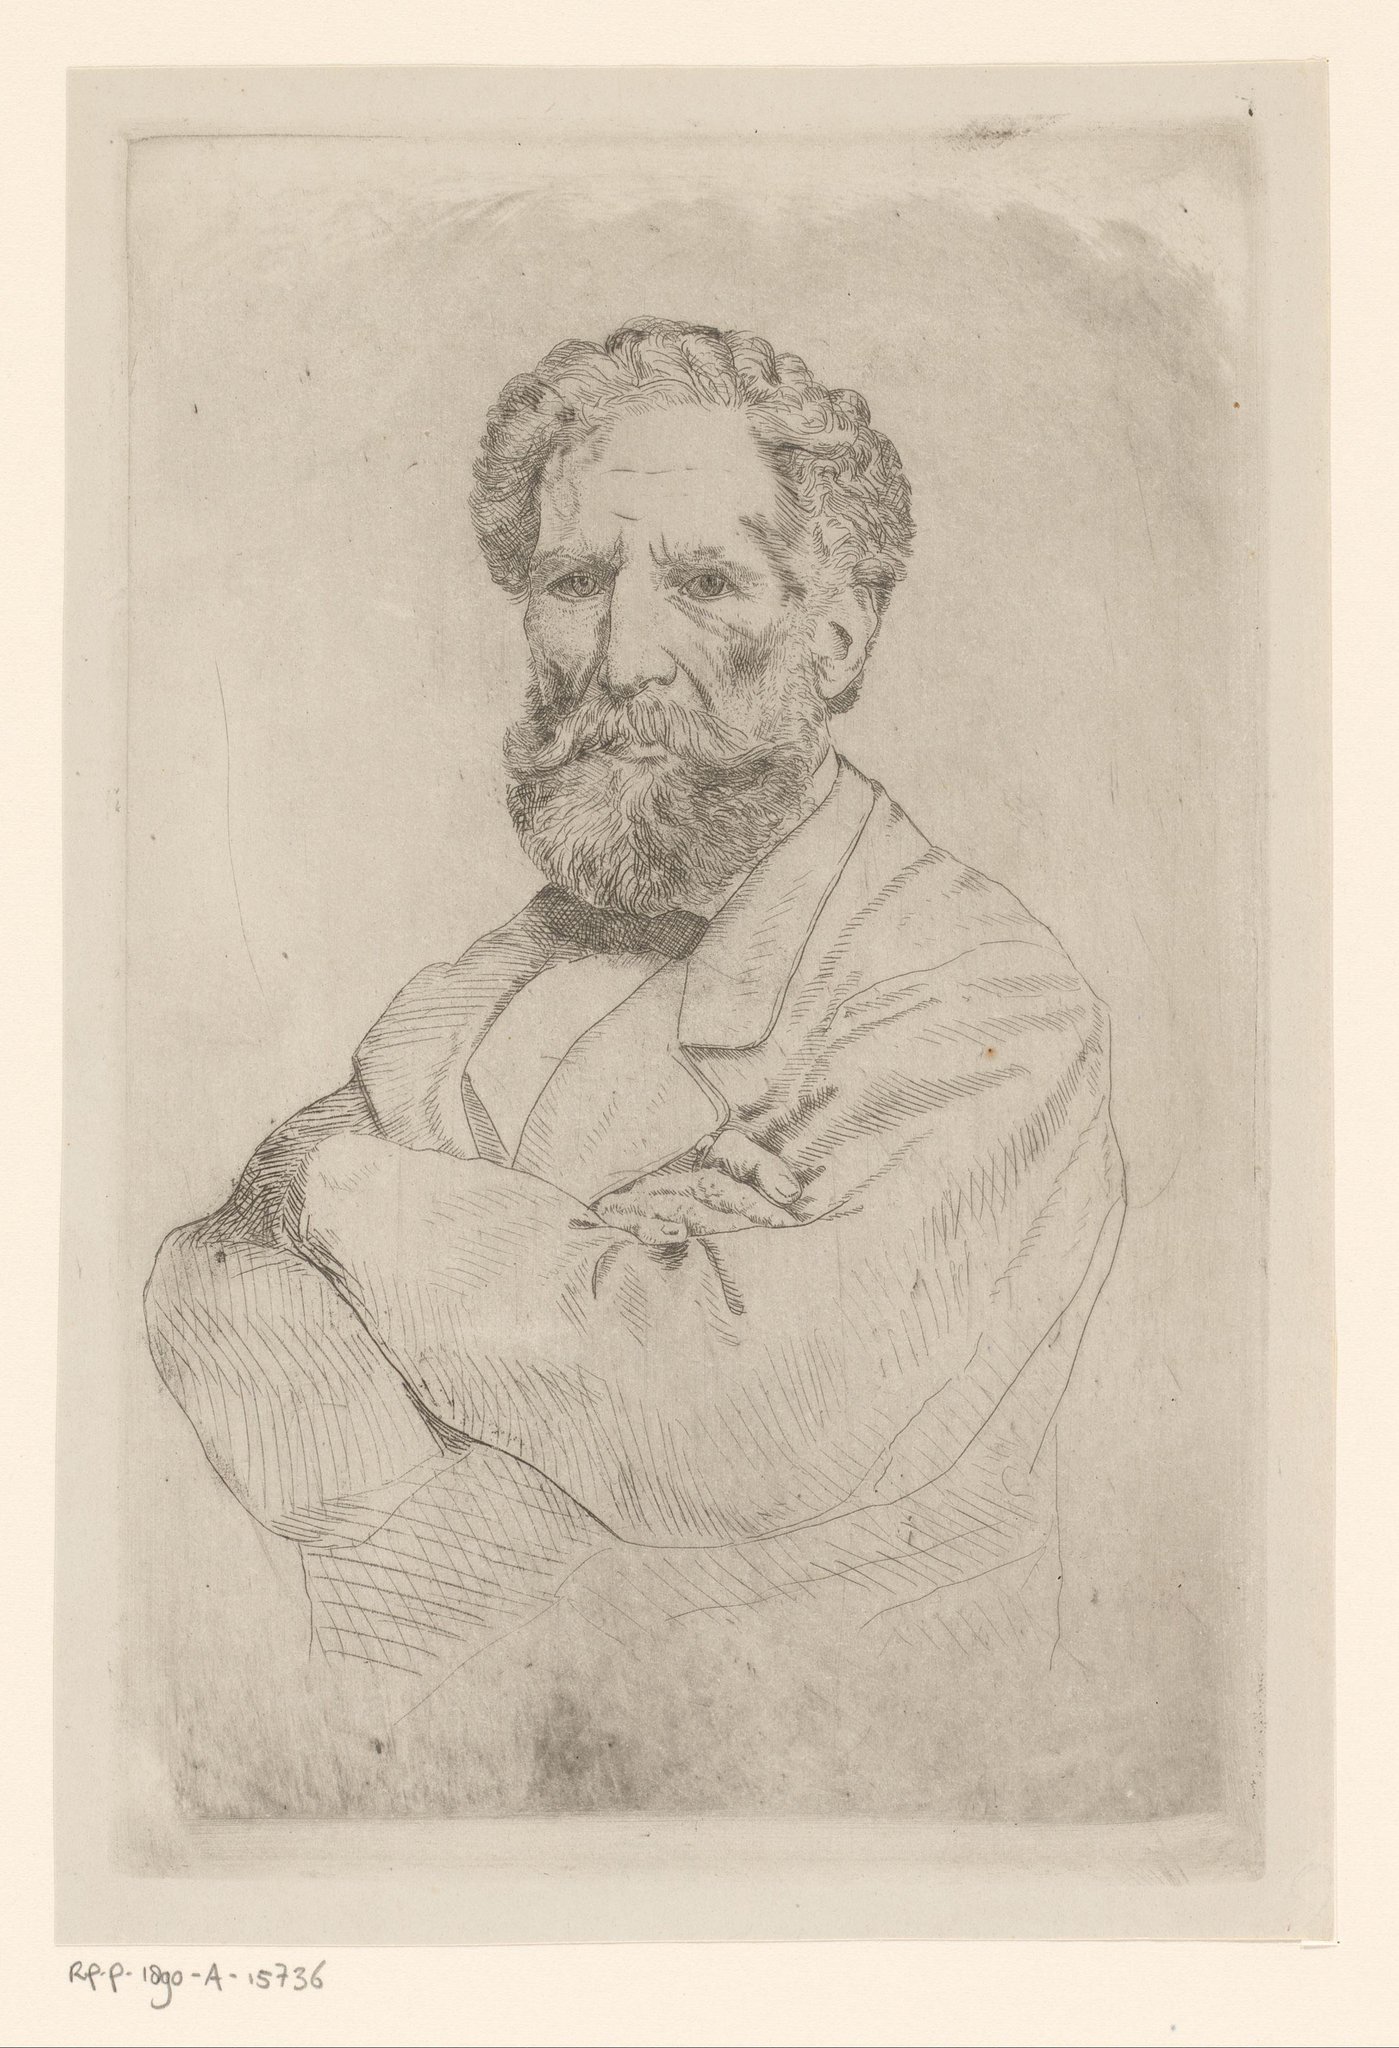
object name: print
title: Zelfportret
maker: karel theodoor hippert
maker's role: print maker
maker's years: 1839-1919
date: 1849-1890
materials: paper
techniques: etching, intaglio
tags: karel theodoor hippert, adult man, historical persons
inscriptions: collector's mark: Lugt 2228